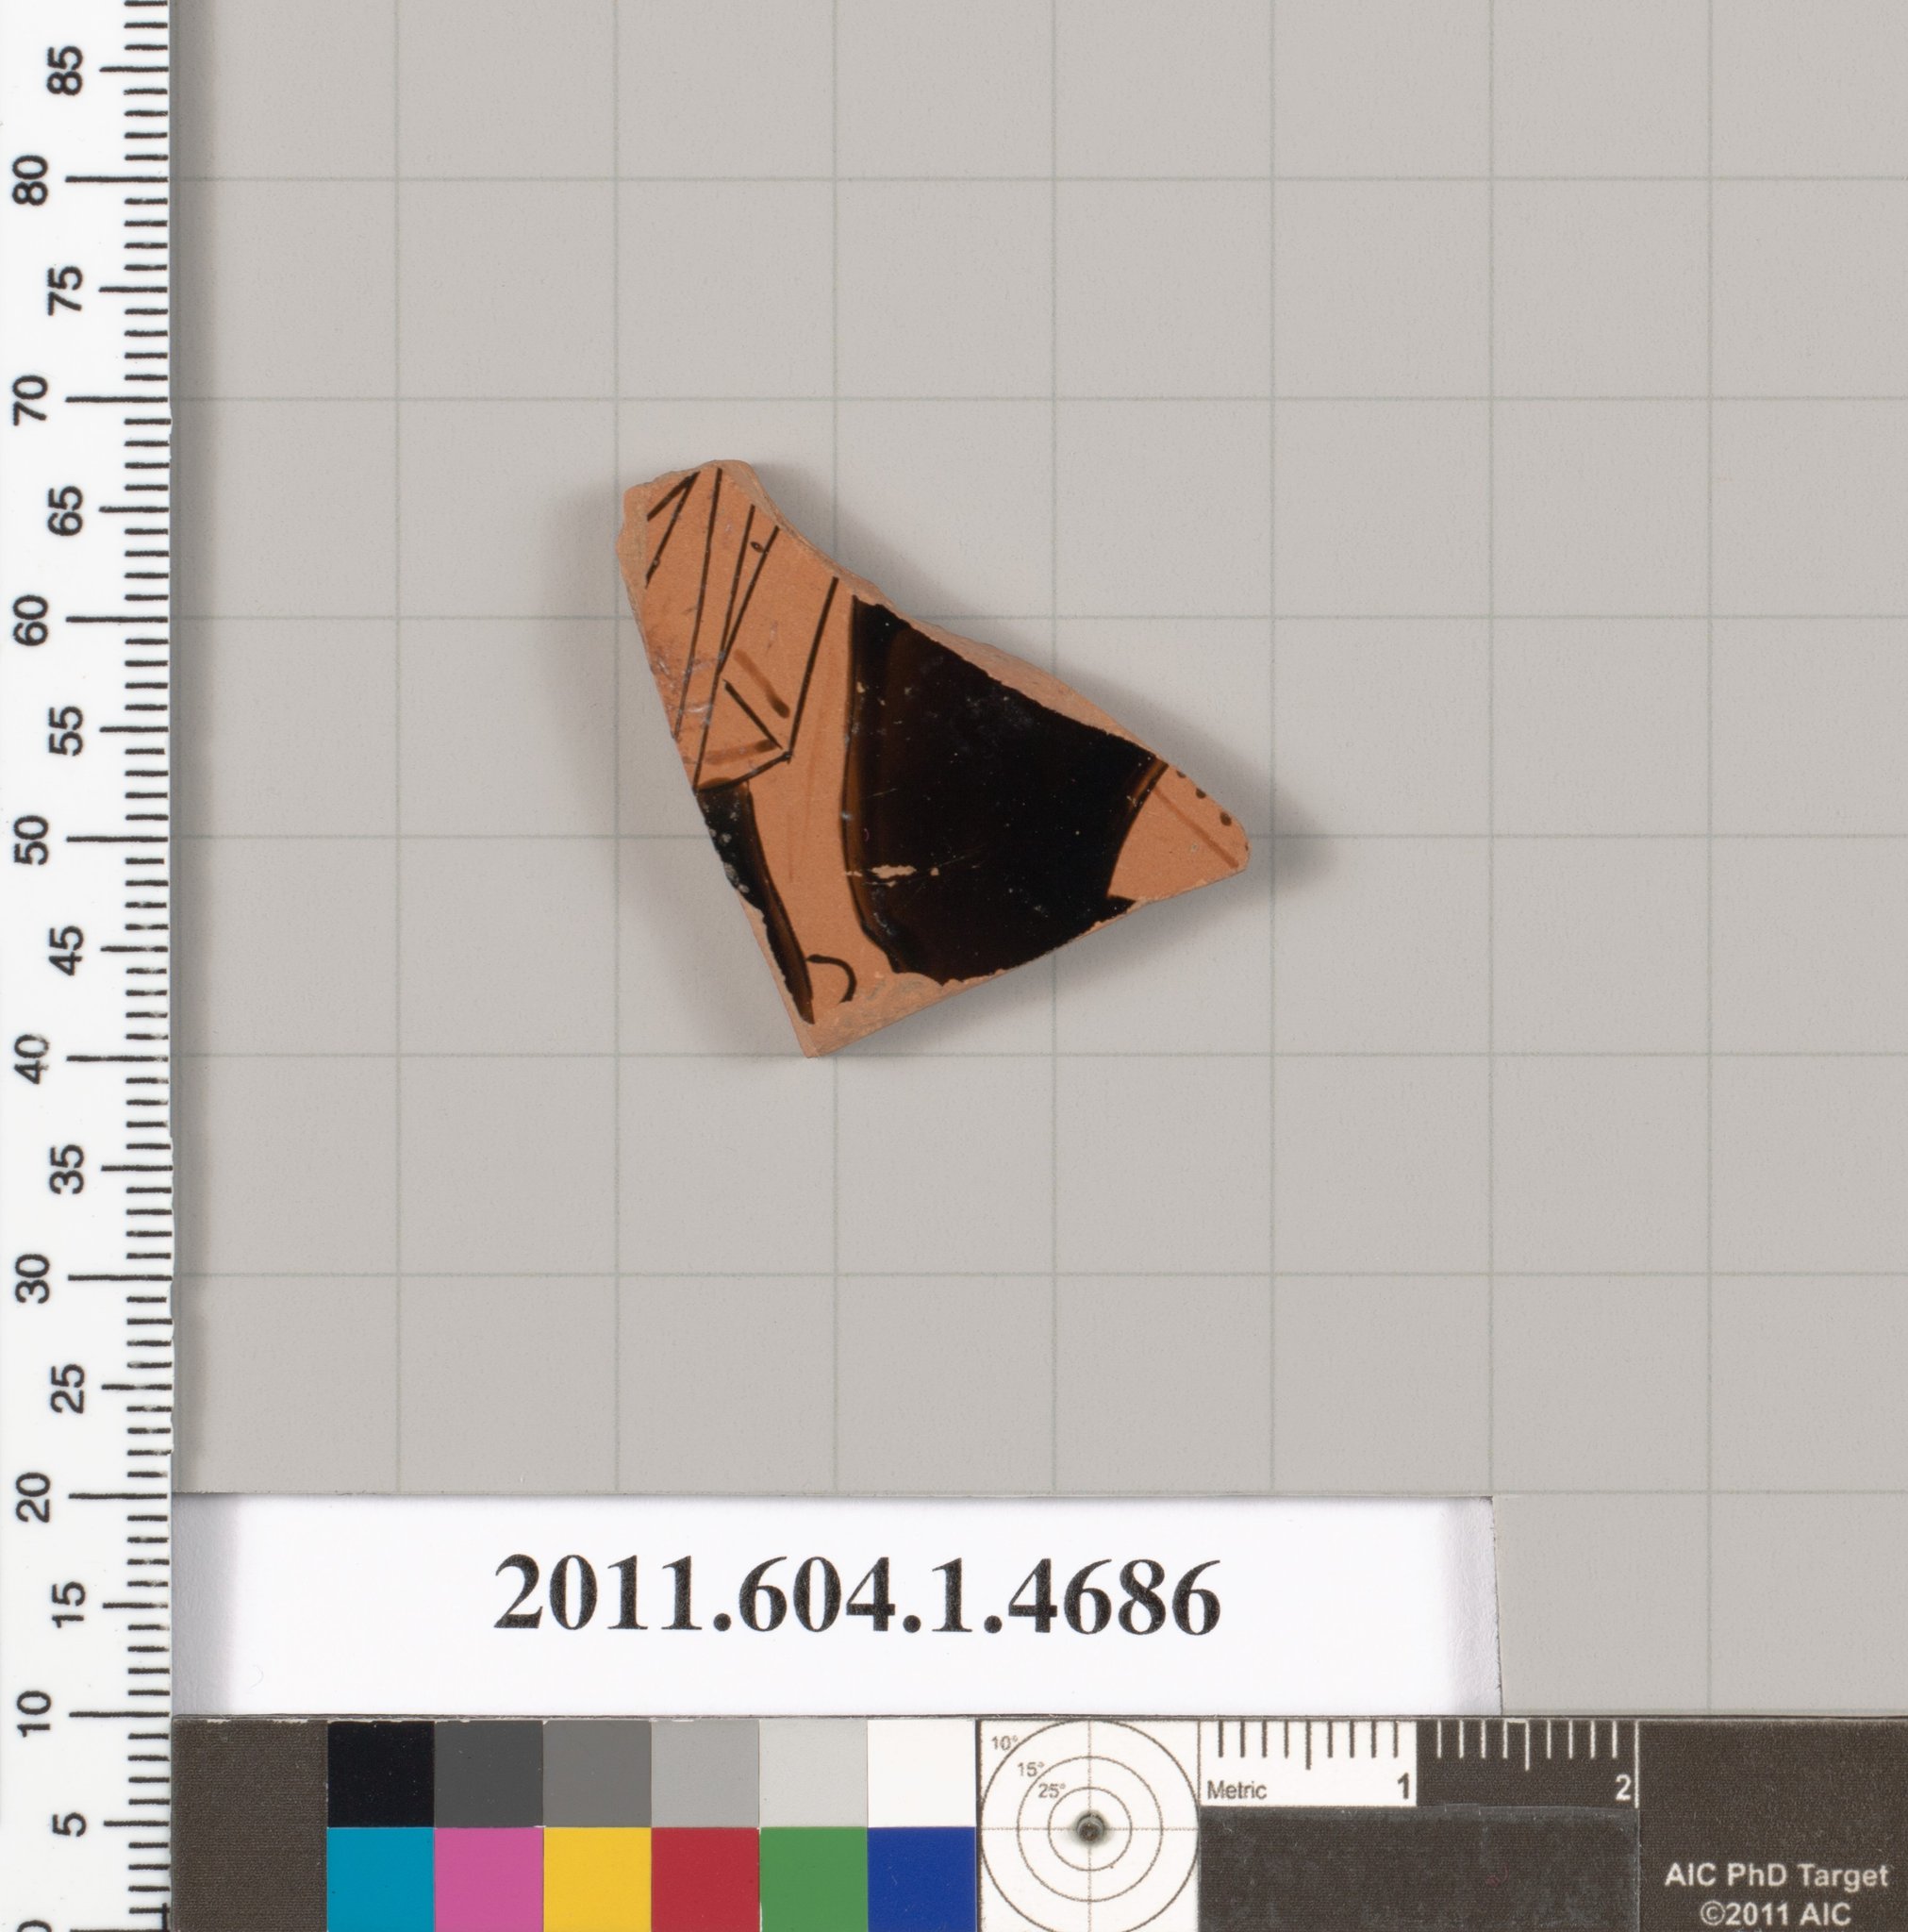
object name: kylix fragment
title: Terracotta fragment of a kylix (drinking cup)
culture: greek, attic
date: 490-470 BCE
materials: terracotta